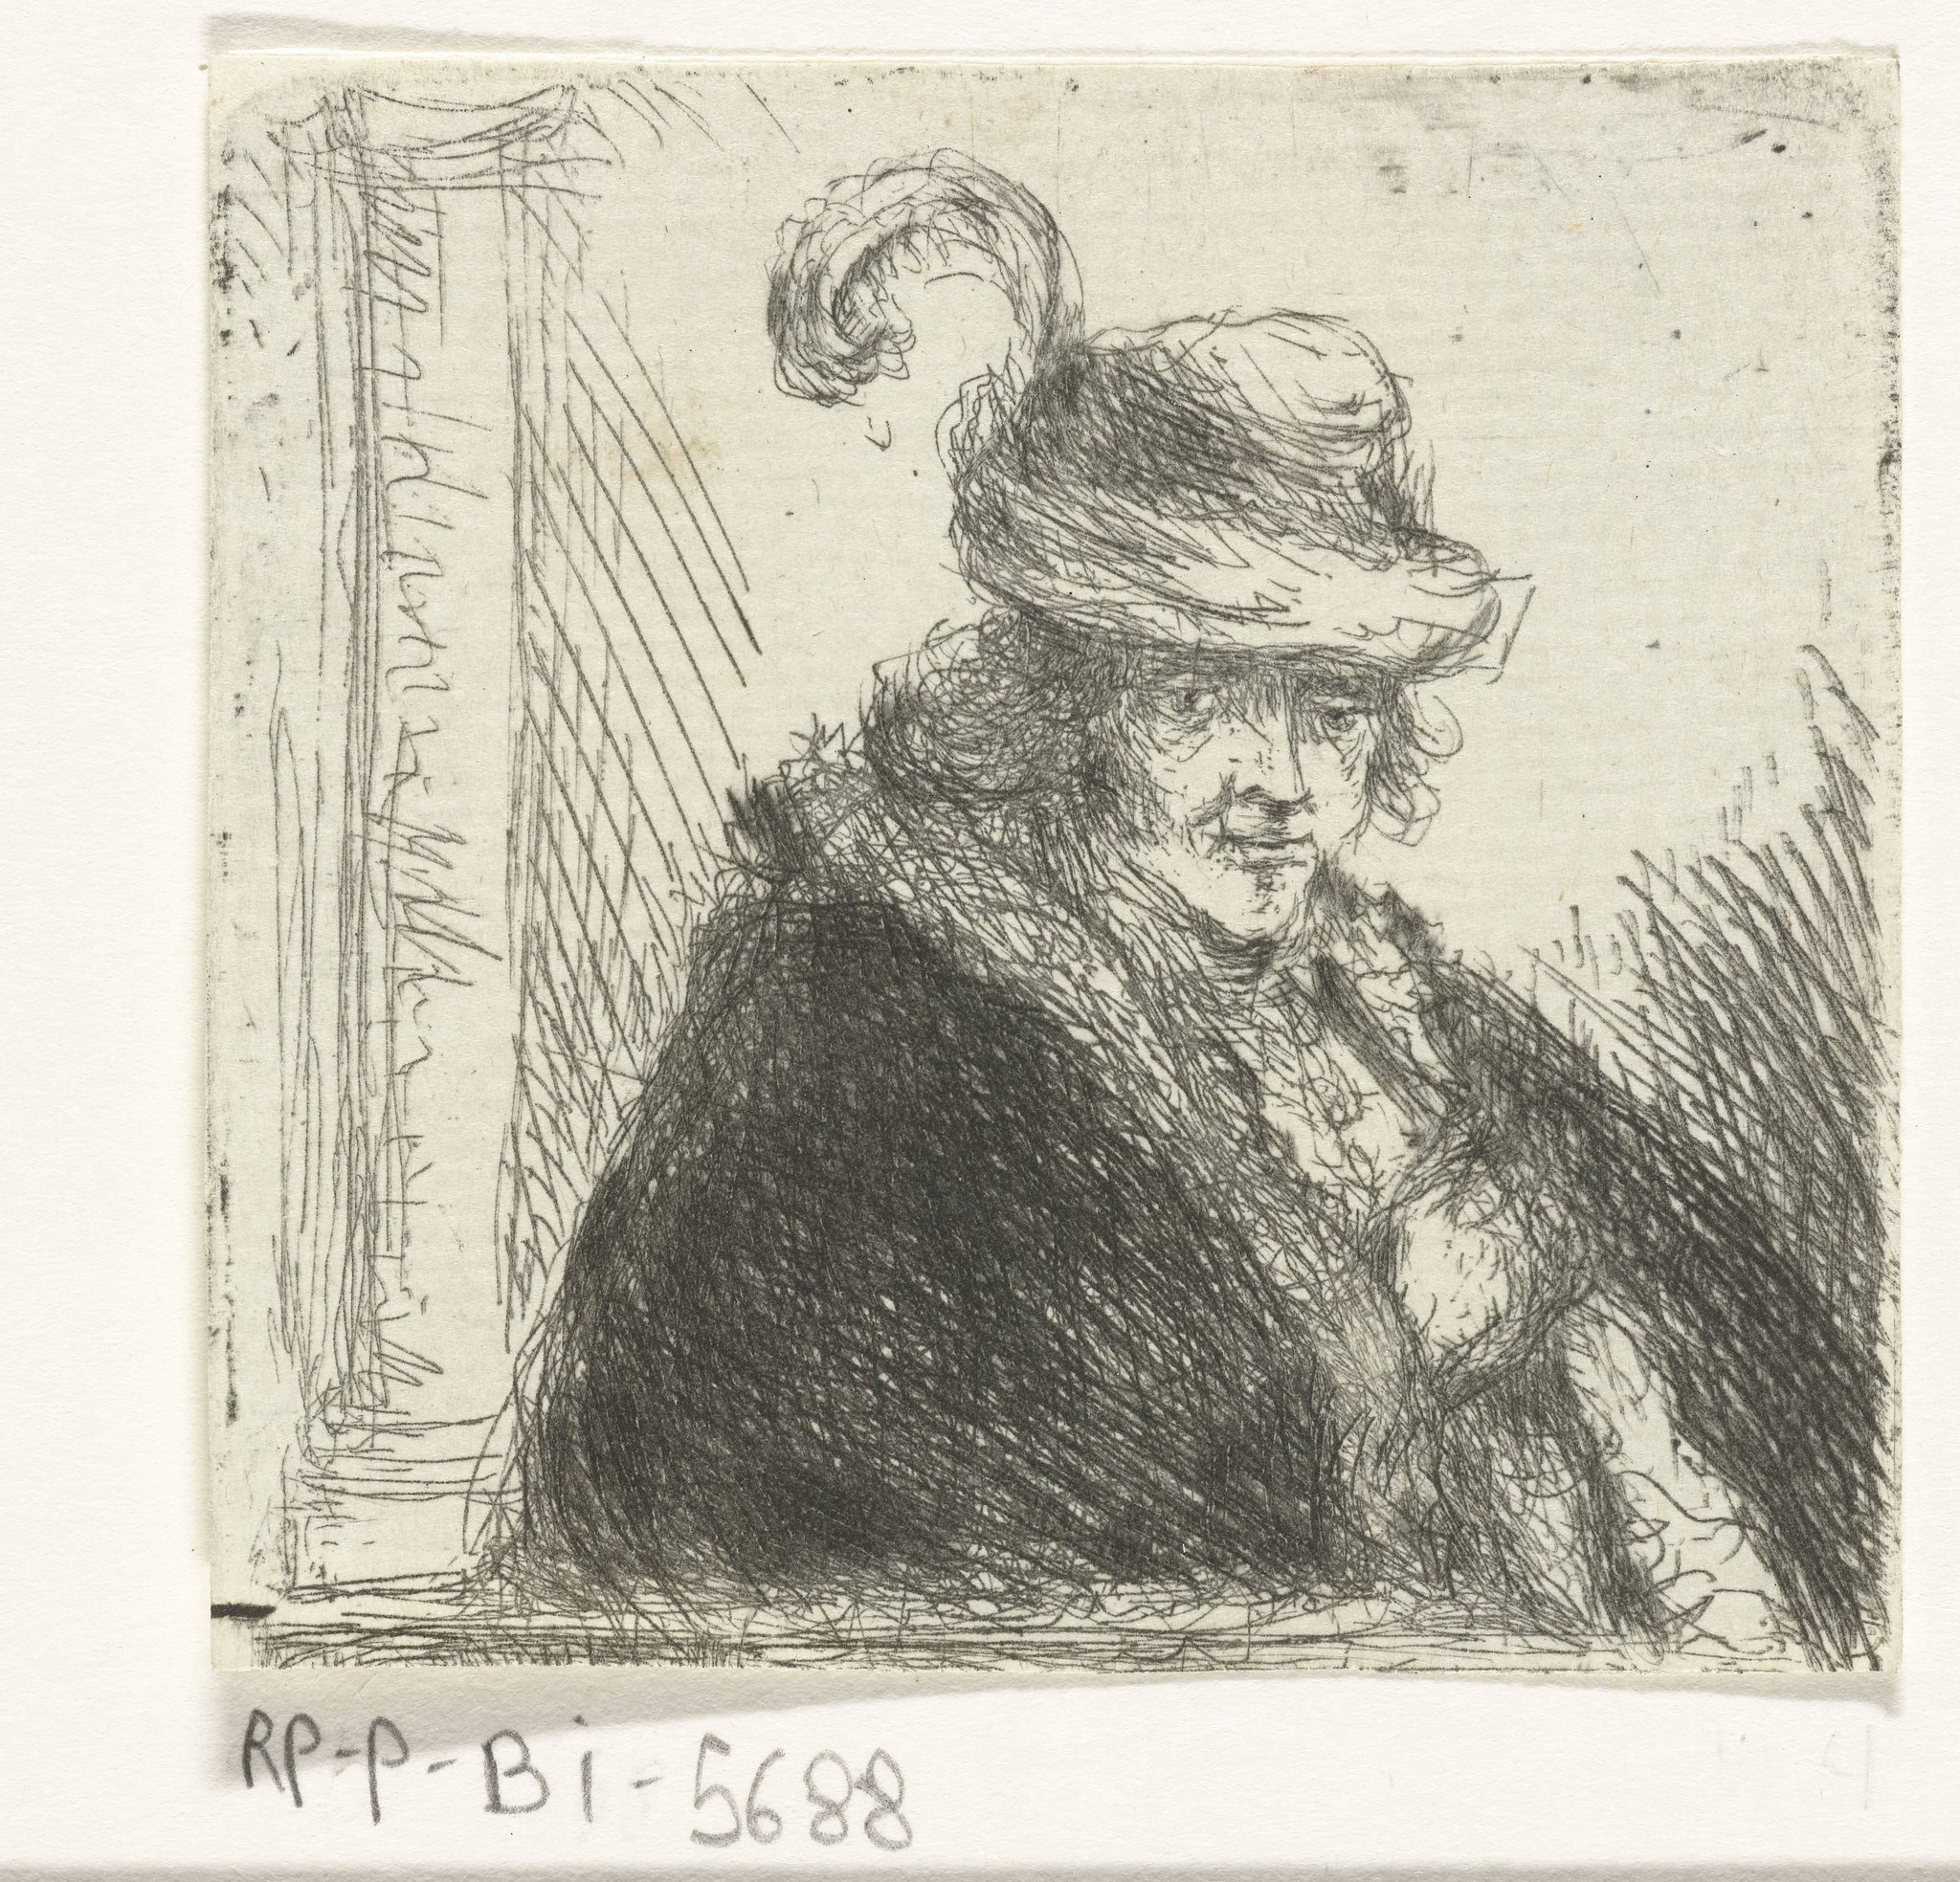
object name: print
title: Man met hoed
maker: jan chalon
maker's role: print maker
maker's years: 1738-1795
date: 1748-1795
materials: paper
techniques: drypoint, etching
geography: northern netherlands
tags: morphology of human expression (+ adult male (human being))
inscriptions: collector's mark: Lugt 2228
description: Een jongeman met hoed en veer. Buste naar rechts. Op de achtergrond links een zuil.